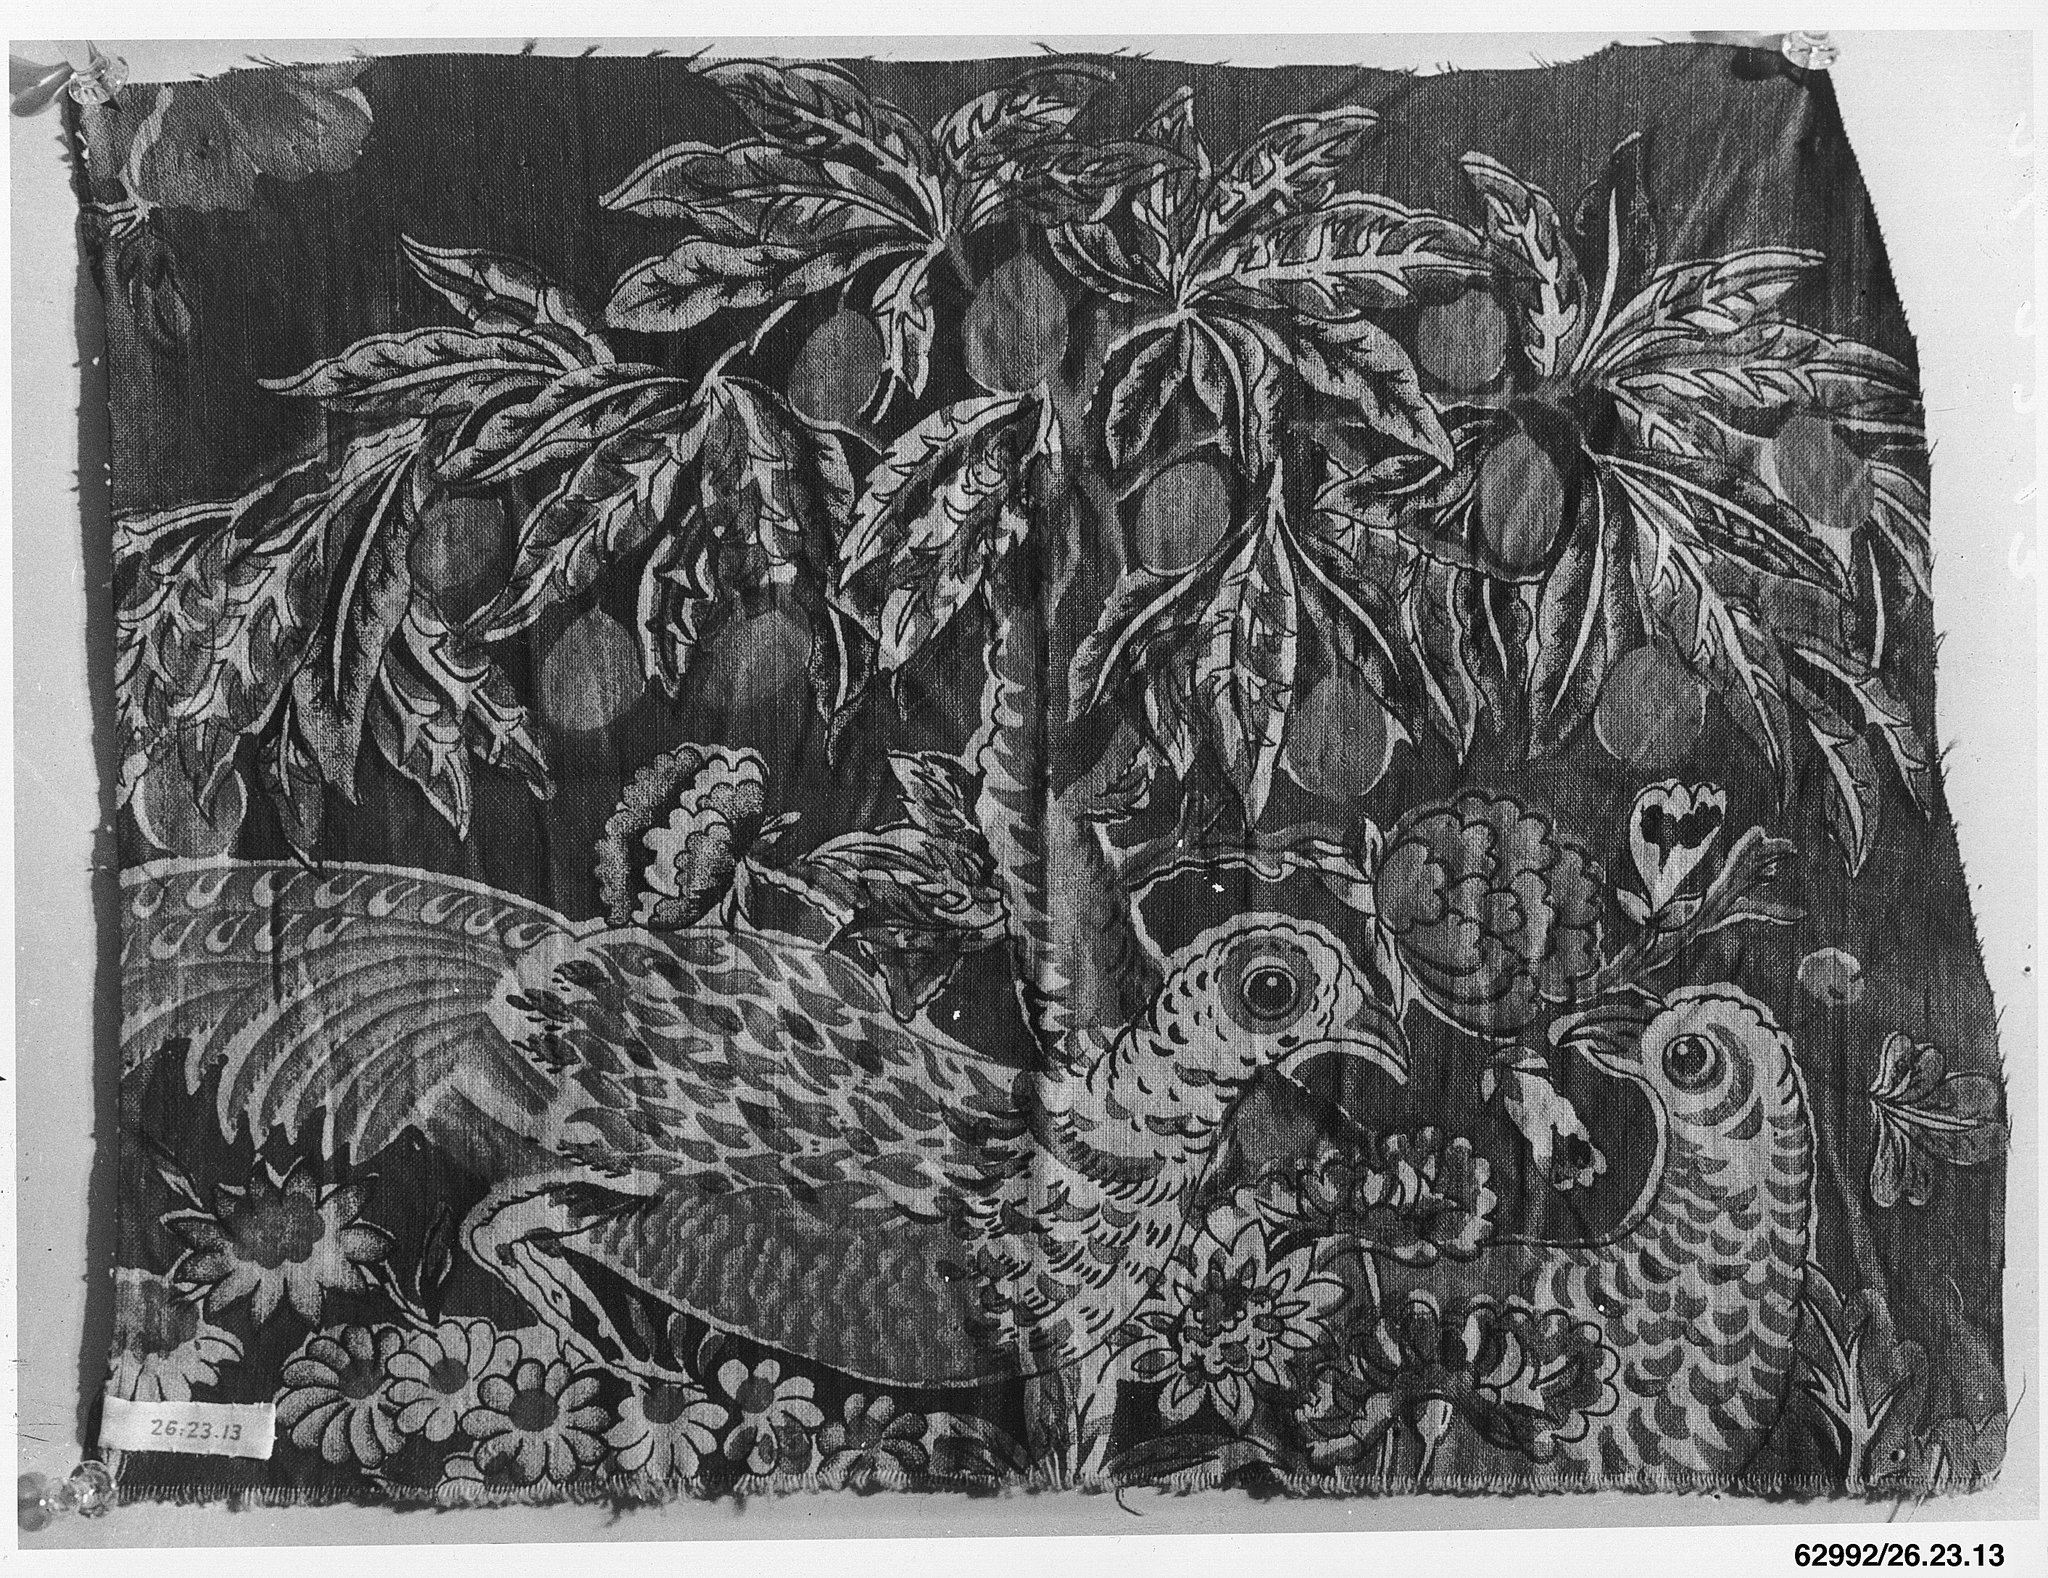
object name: piece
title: Fragment of textile printed with game birds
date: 1825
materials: cotton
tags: birds,fruit,flowers,leaves